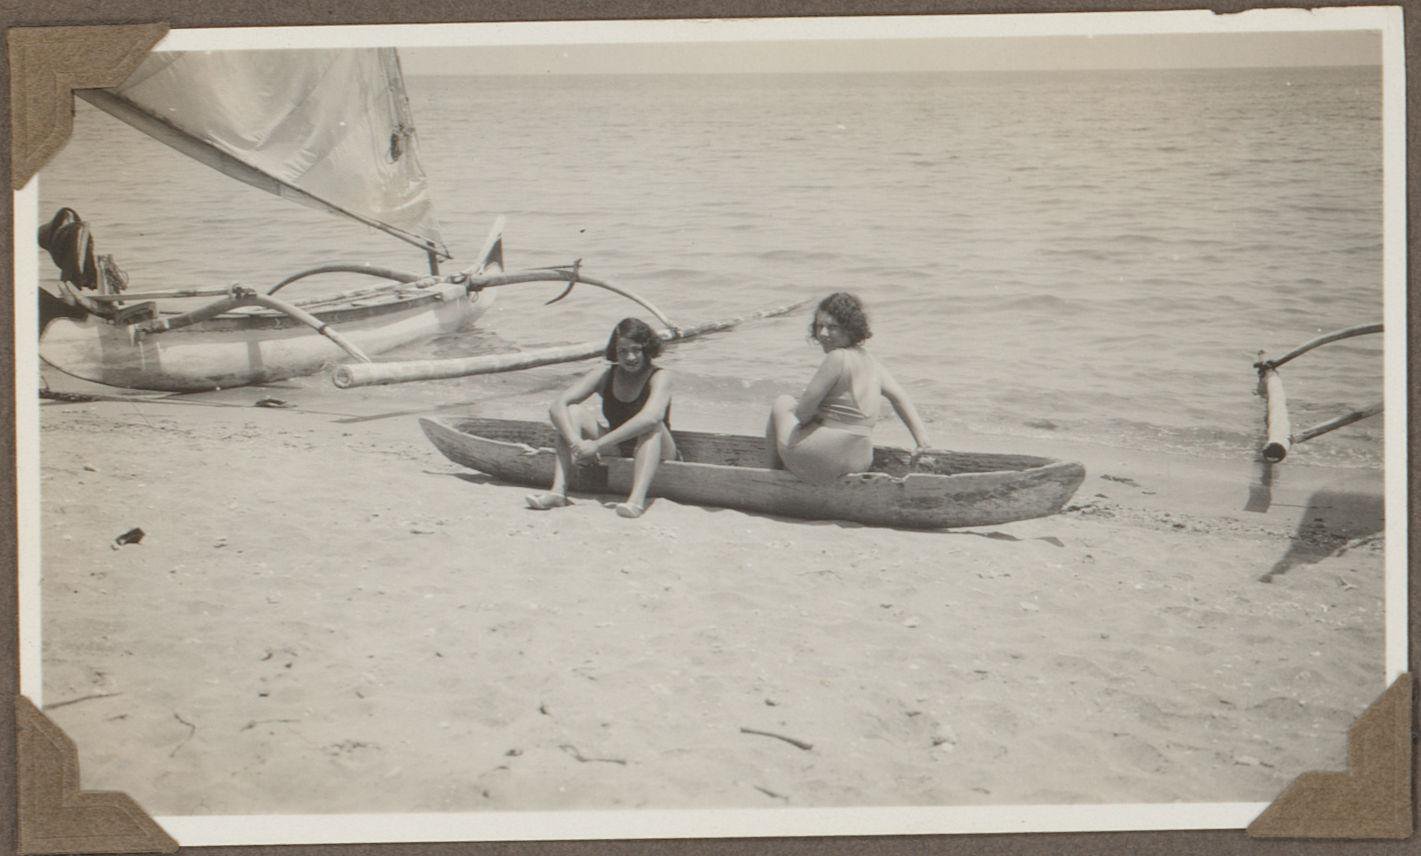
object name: photograph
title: Twee vrouwen in een prauw aan het strand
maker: Anonymous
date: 1930-1935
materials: paper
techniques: gelatin silver print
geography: dutch east indies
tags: adult woman, rowing-boat, canoe, etc., dutch east indies, the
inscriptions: inscription: ‘Pasir Poefik bij/ Probakin op./ Zondag 5 October.’